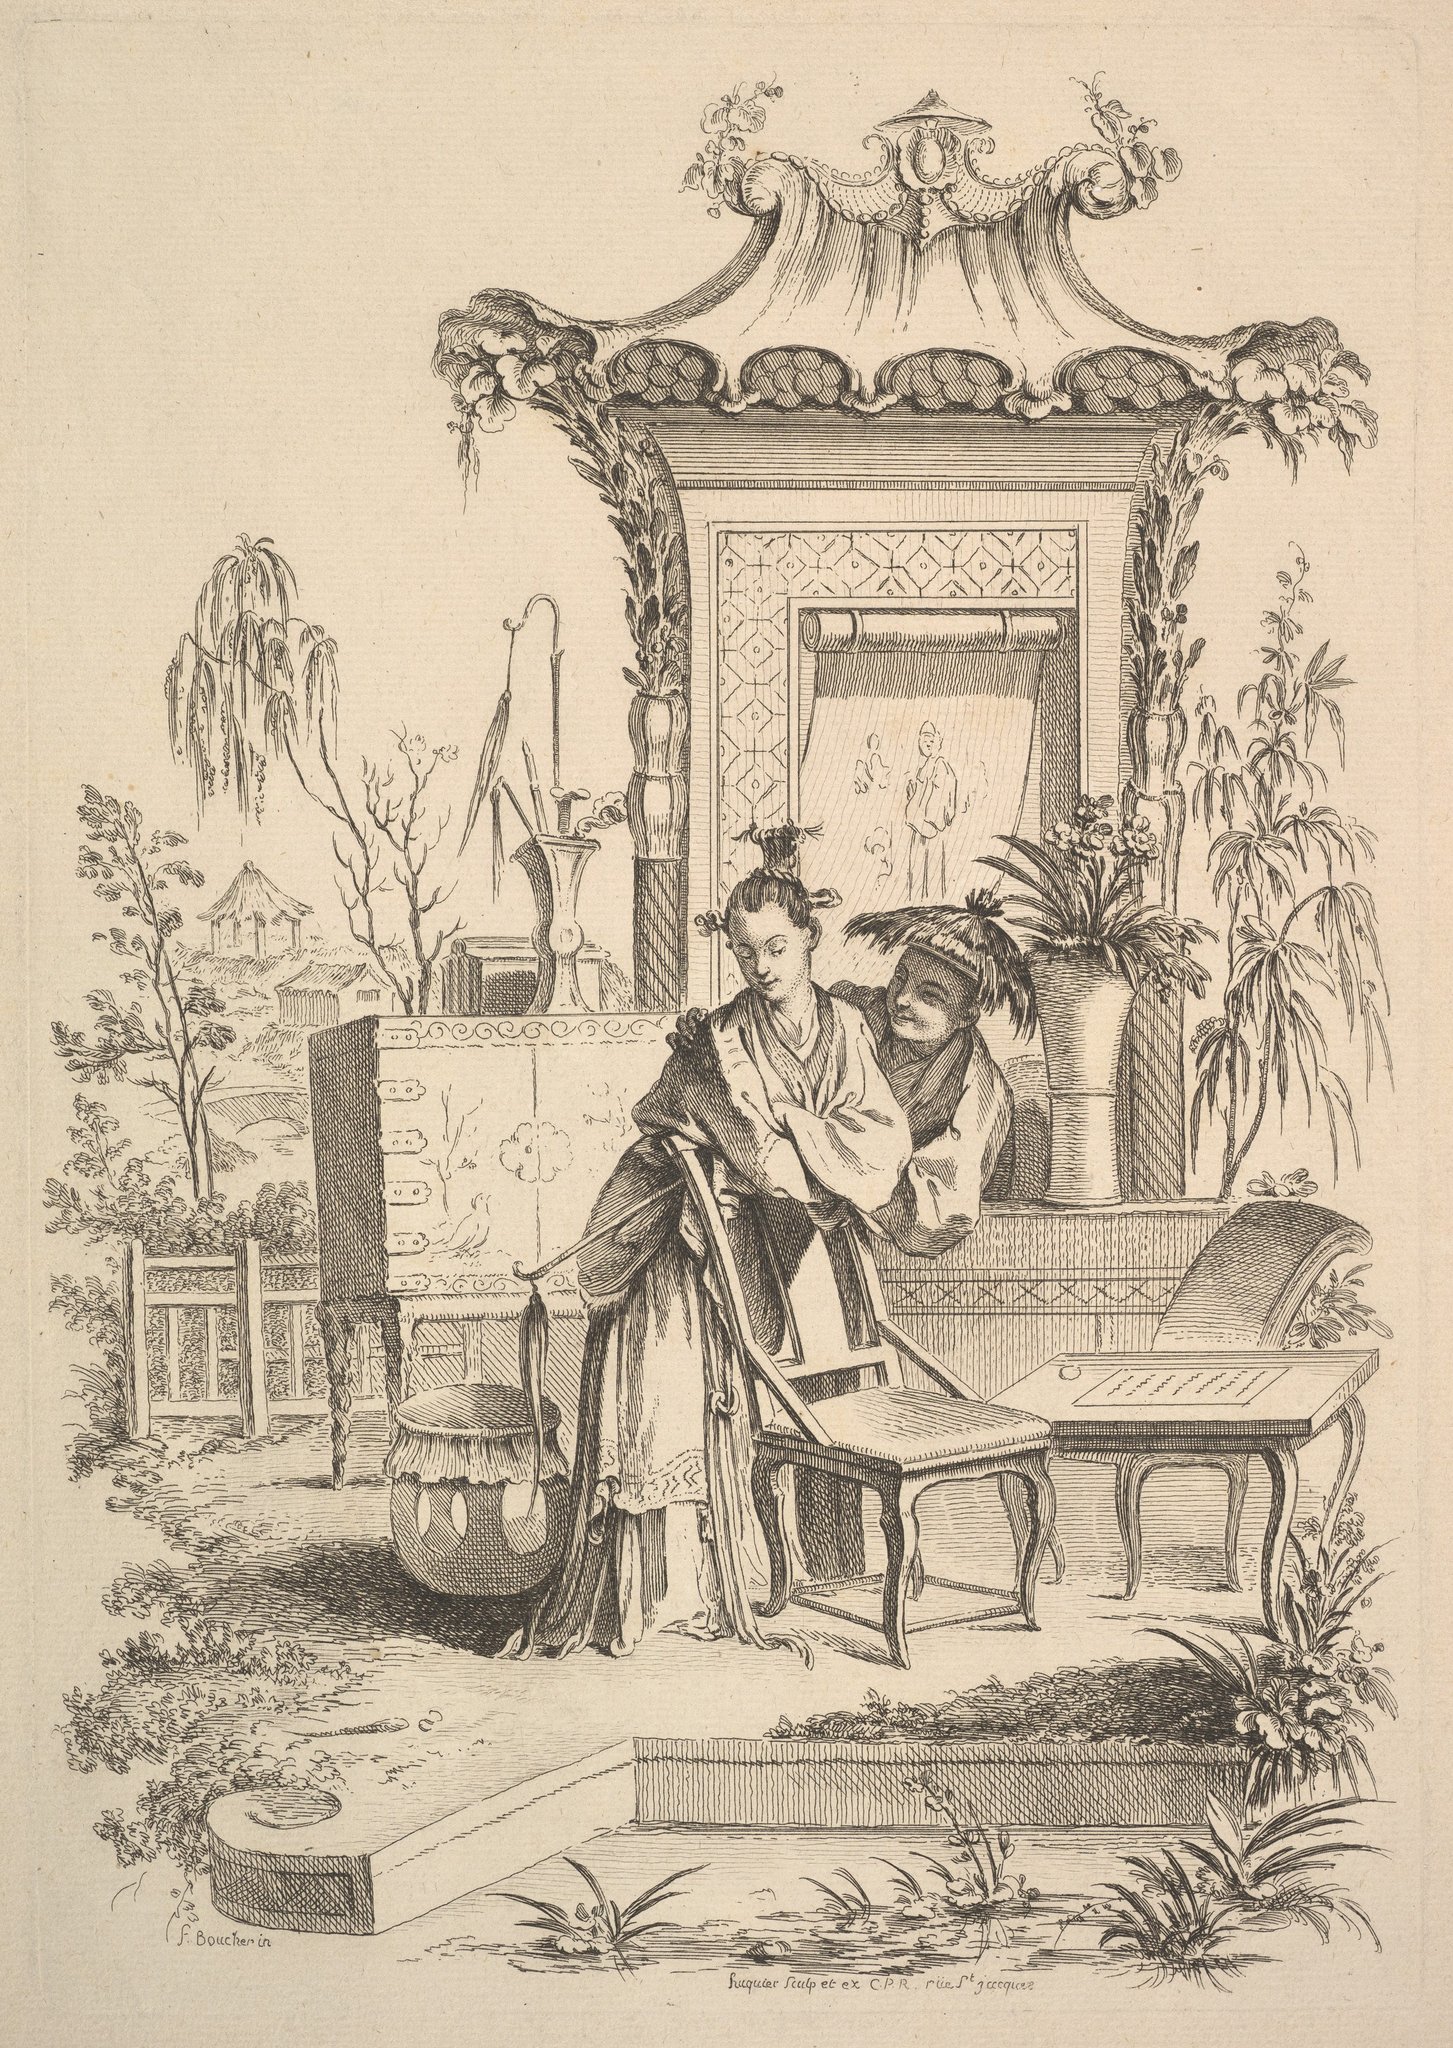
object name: print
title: Chinese Man and Woman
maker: gabriel huquier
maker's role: artist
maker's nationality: french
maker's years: 1695-1772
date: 1742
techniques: engraving, etching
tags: chinoiserie,men,women,chairs